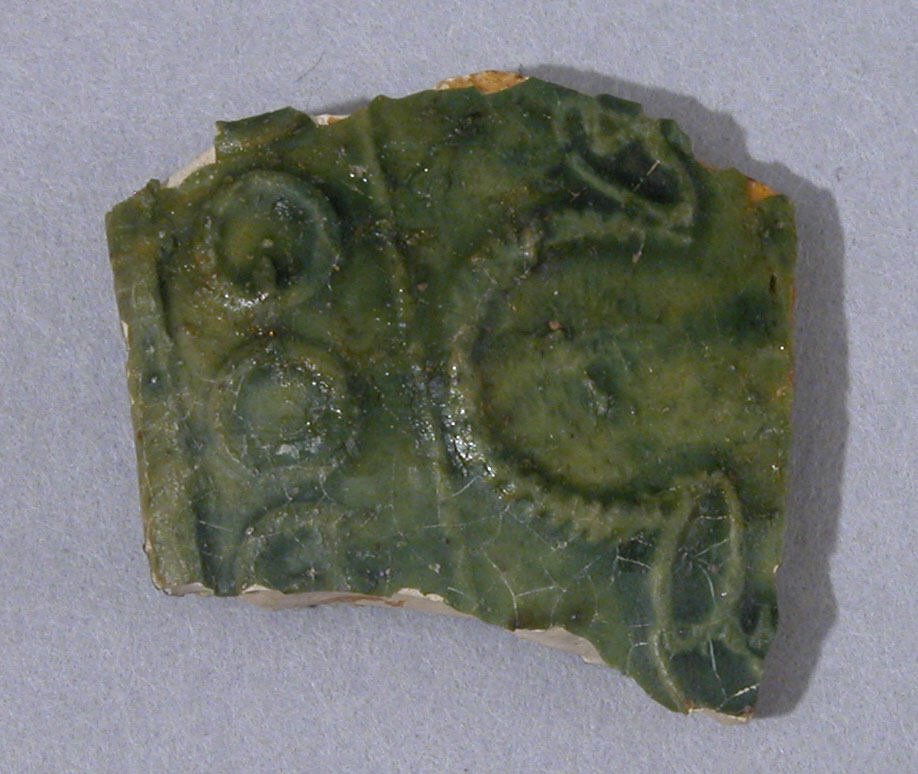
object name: fragment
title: Ceramic Fragment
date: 801-900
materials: earthenware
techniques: glazing, molding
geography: saudi arabia